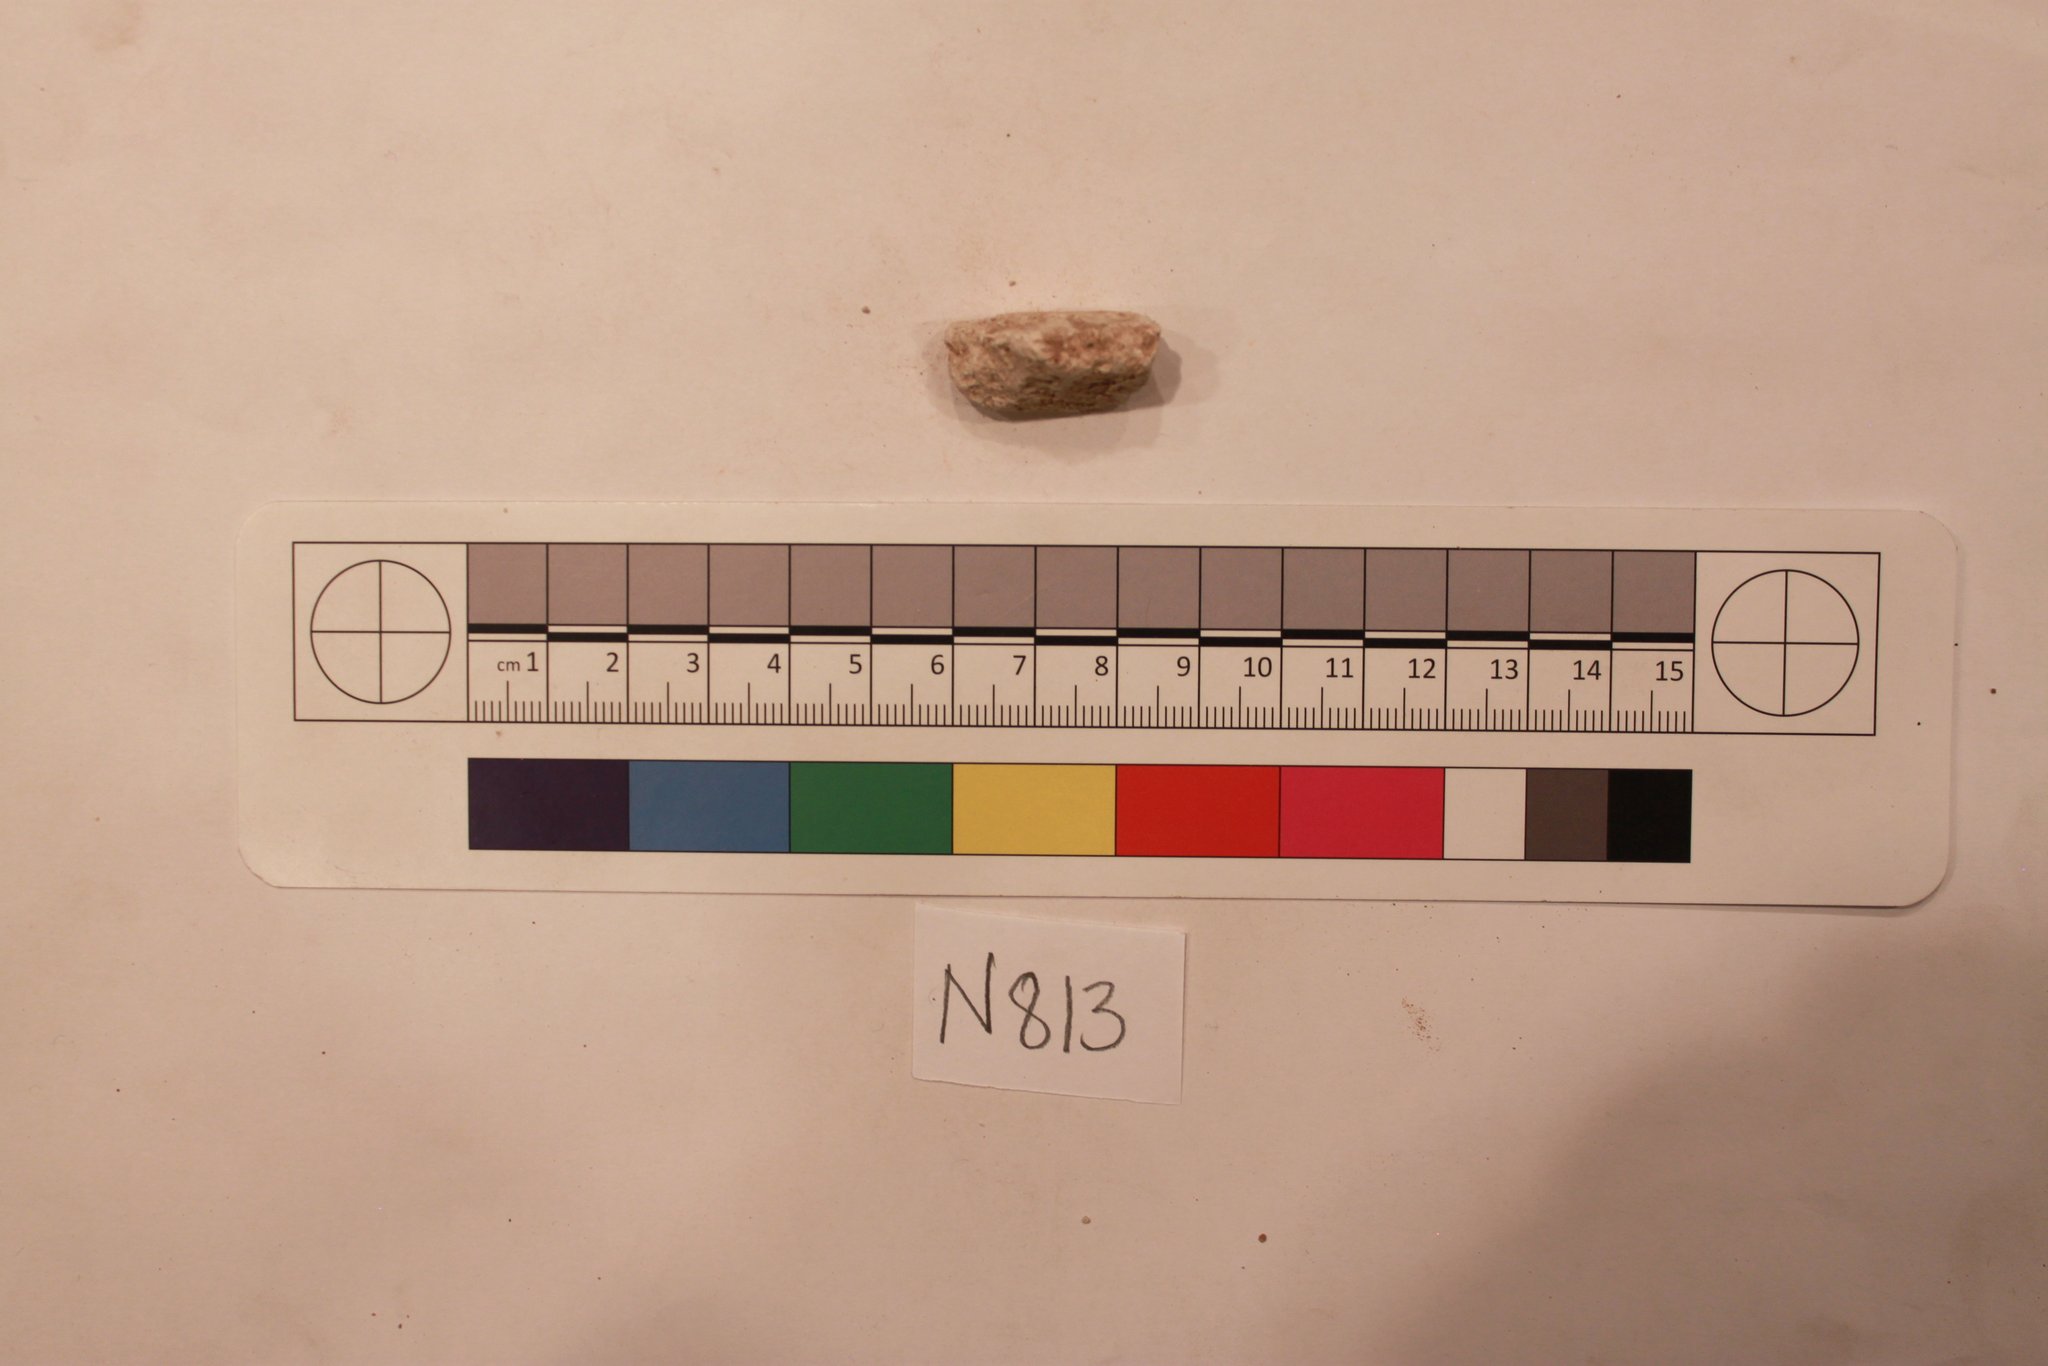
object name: fragment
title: Stucco Fragment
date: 701-1200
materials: plaster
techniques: carving, painting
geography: iran